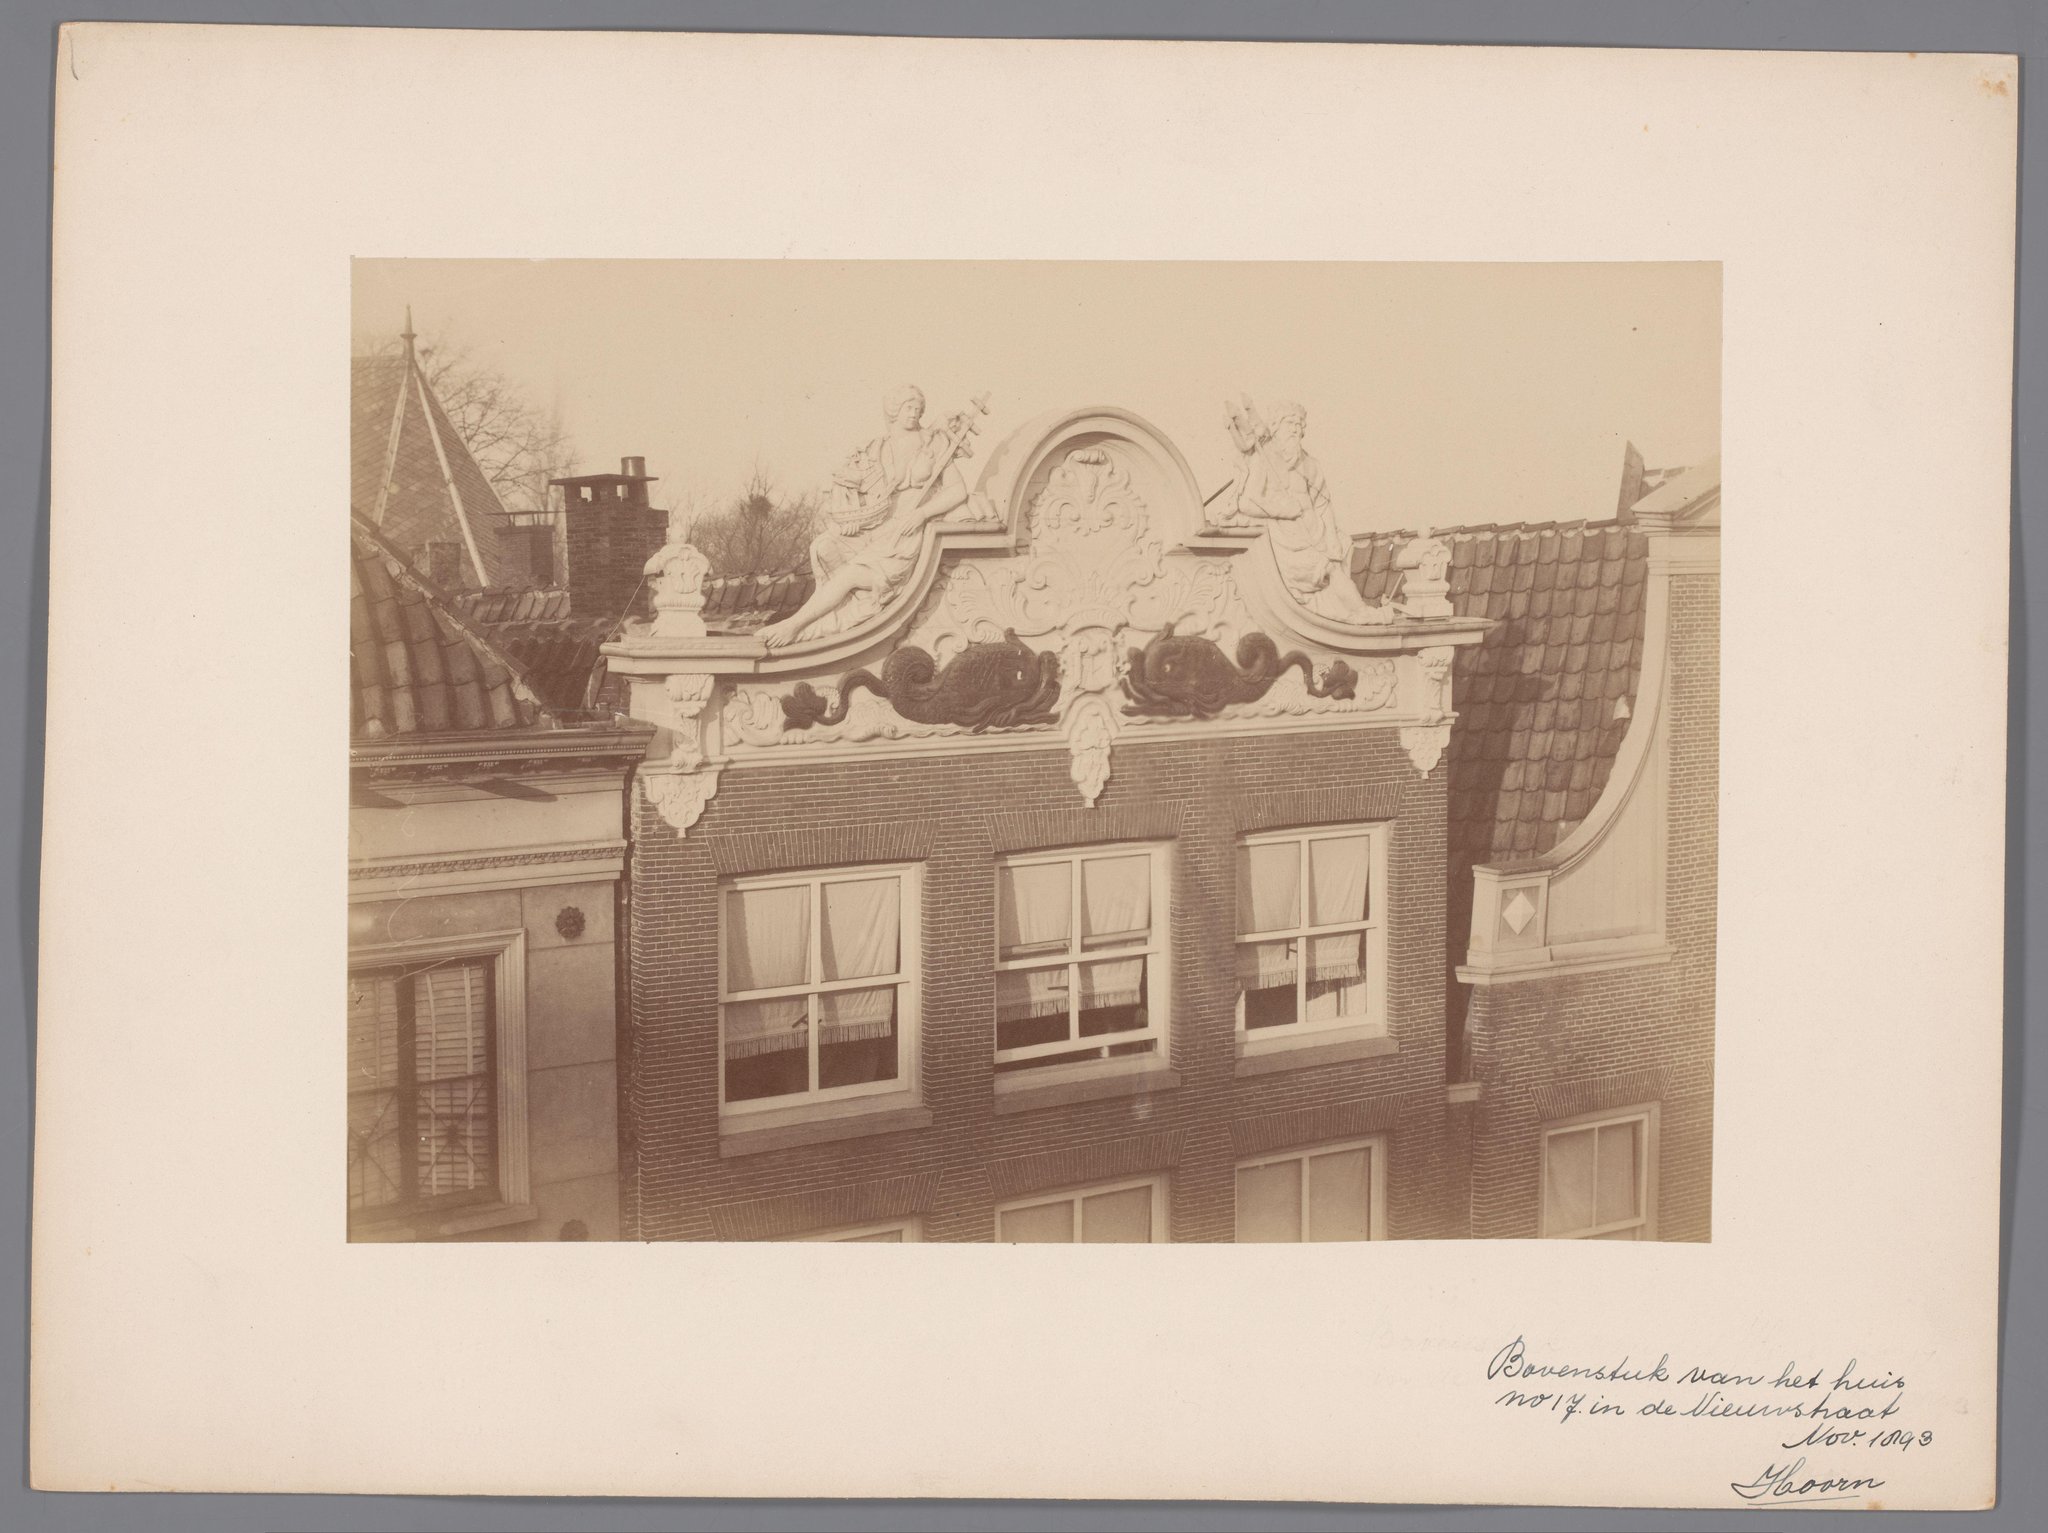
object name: photograph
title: Façade van Nieuwstraat 17 te Hoorn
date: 1893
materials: cardboard, photographic support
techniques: albumen print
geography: nieuwstraat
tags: urban housing, piece of sculpture, reproduction of a piece of sculpture, façade (of house or building)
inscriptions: annotation: ‘Hoorn (N.H.)/ bovenstuk van het huis N:17 in de Nieuwstraat/ Nov. 1893’, annotation: ‘Bovenstuk van het huis no 17 in de Nieuwstraat Nov. 1893/ Hoorn’